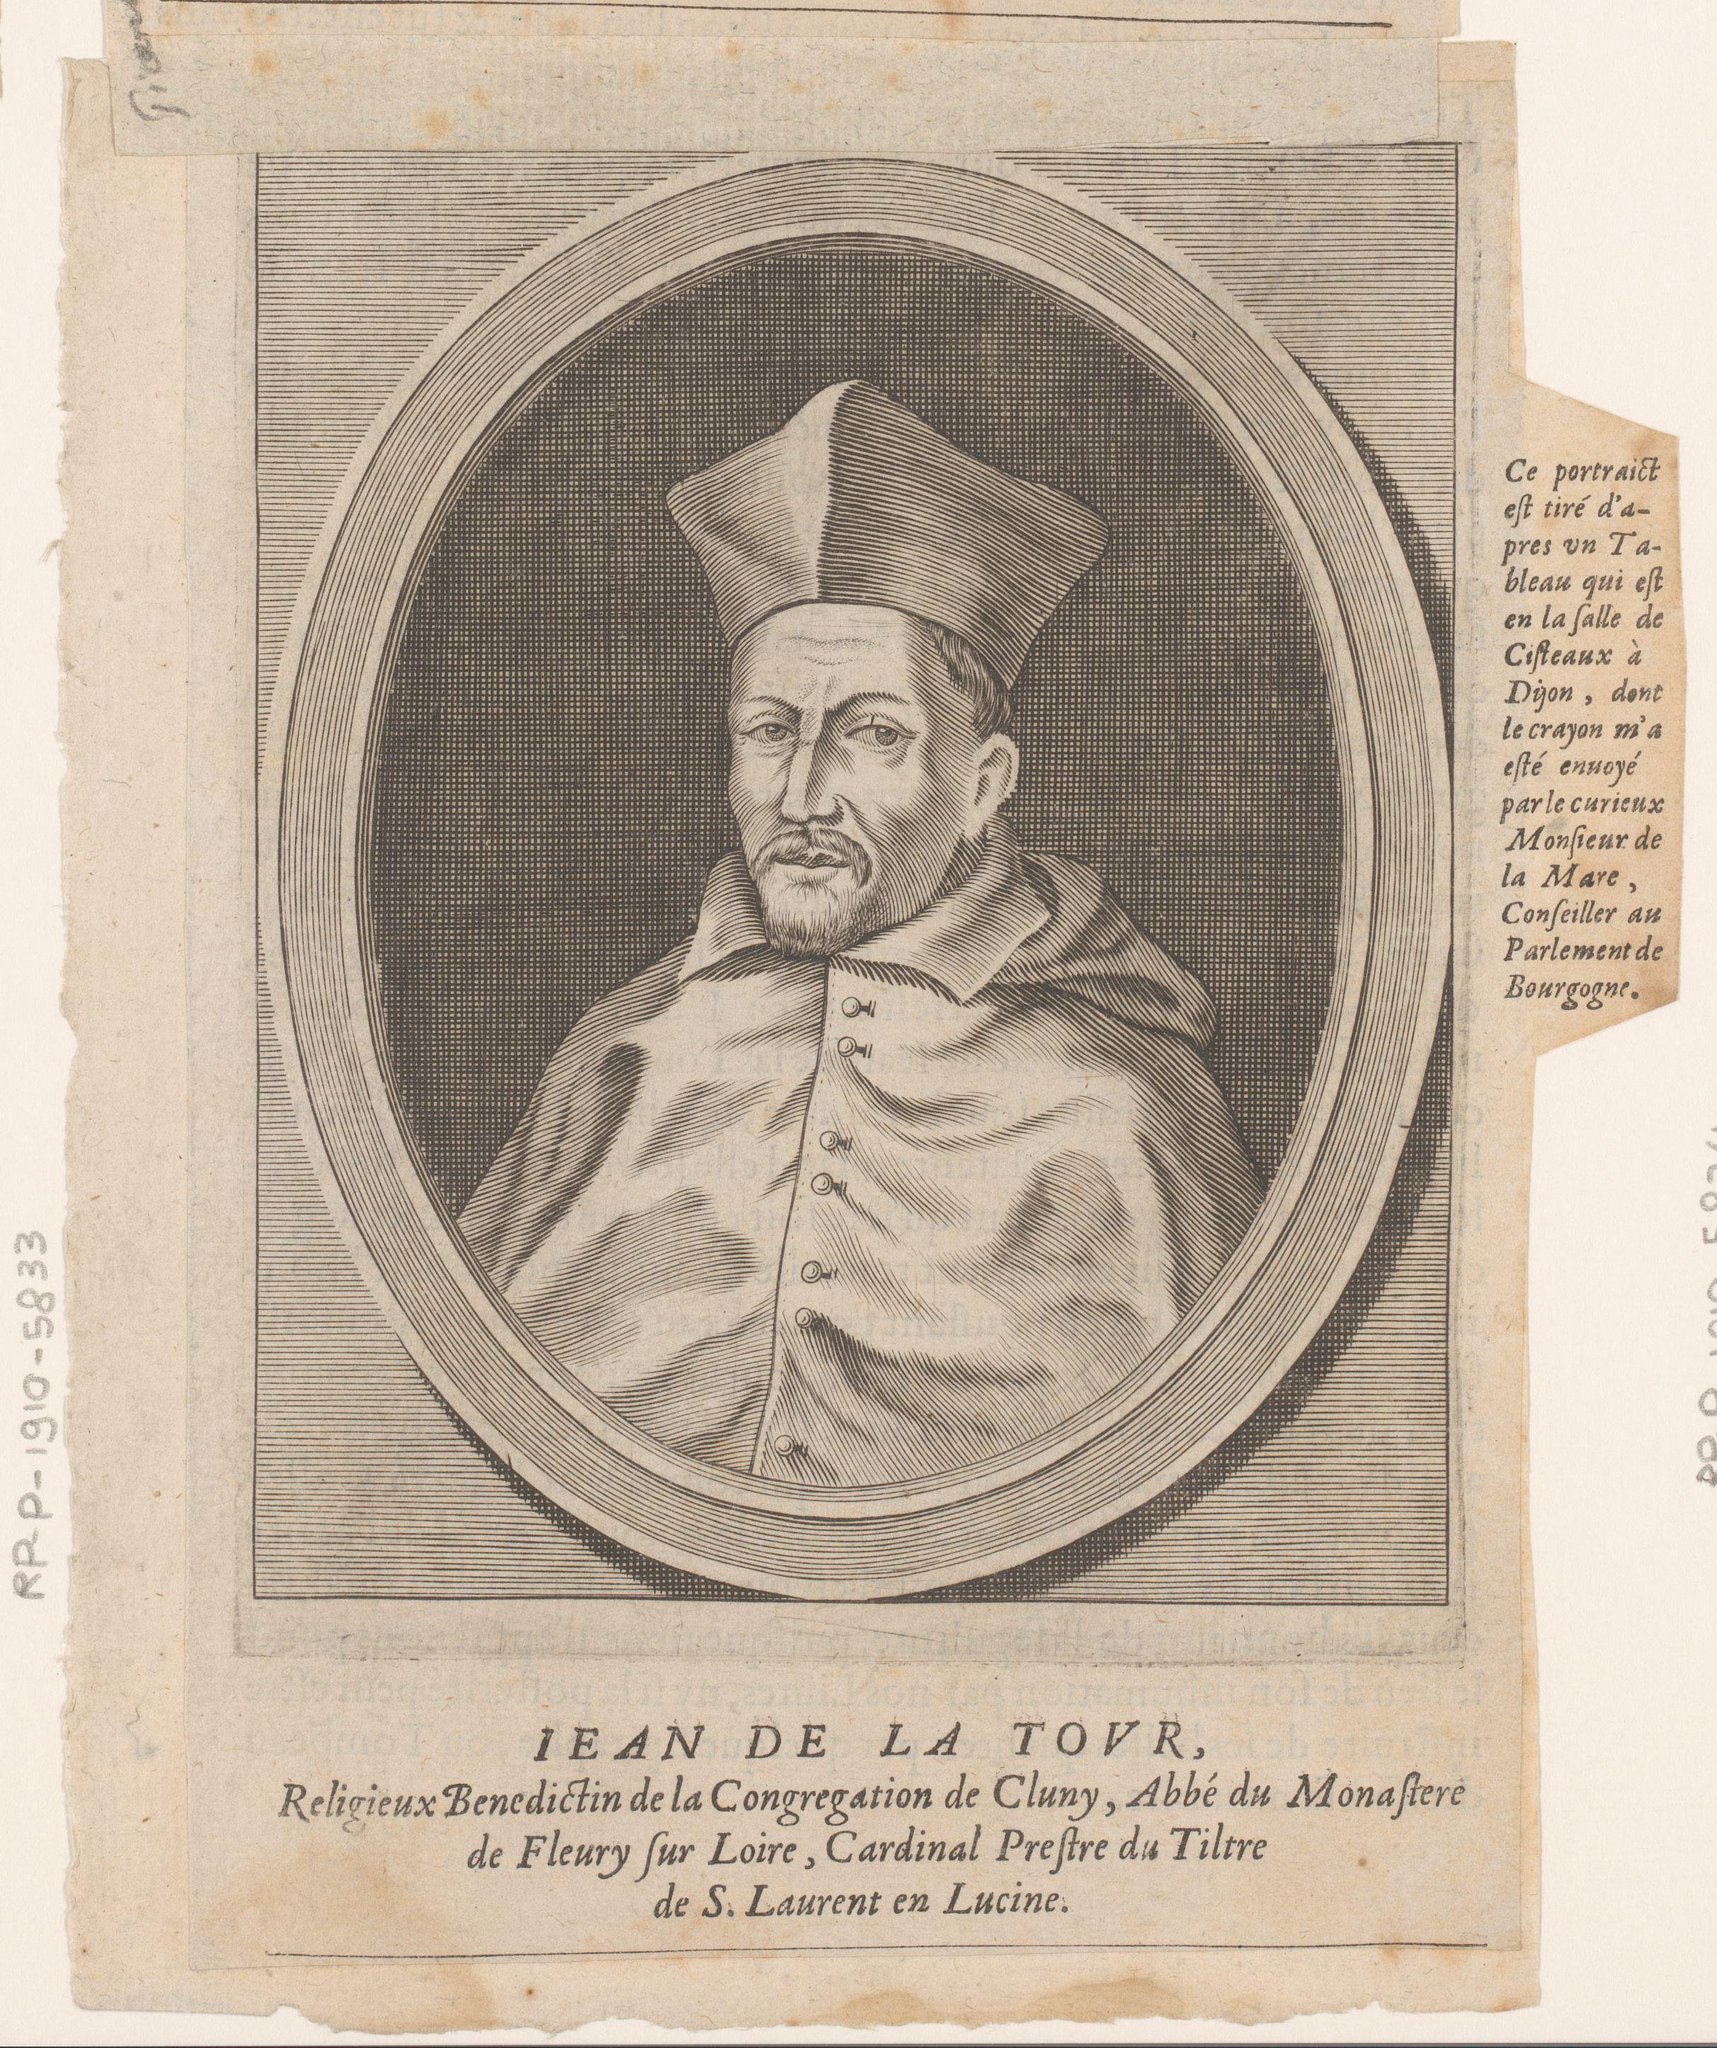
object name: book illustration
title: Portret van Jean de La Tour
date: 1660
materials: paper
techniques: engraving, etching, letterpress printing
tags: cardinal, historical persons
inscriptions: collector's mark: Lugt 2228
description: Prent uit: Du Chesne, François. Histoire de tous les cardinaux françois de naissance, ou qui ont esté promeus au cardinalat. Parijs: François Du Chesne, 1660.